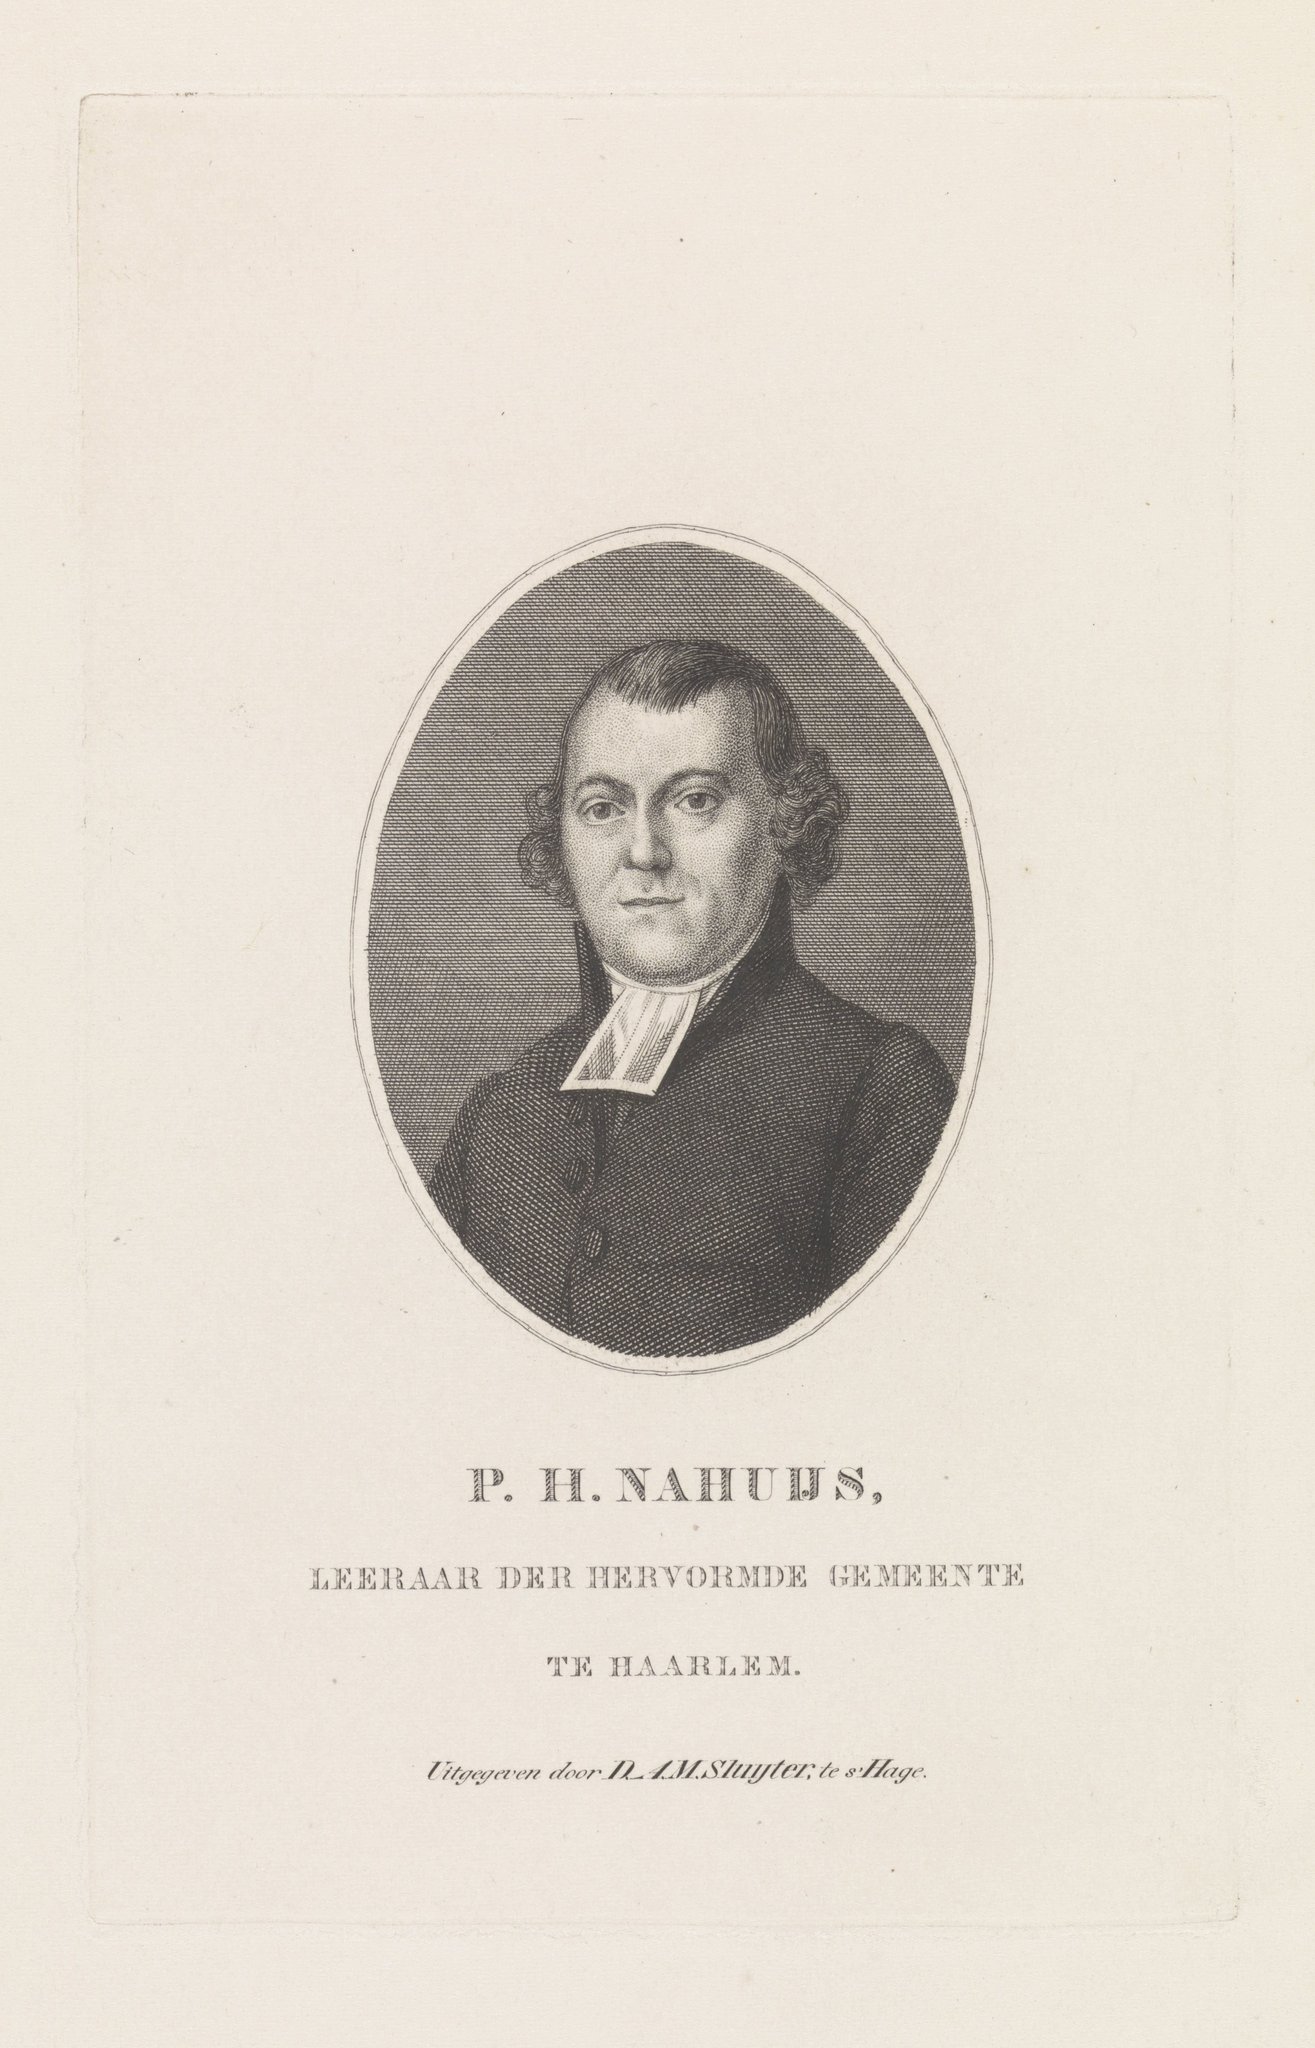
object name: print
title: Portret van Pieter Huibert Nahuys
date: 1810-1837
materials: paper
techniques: engraving, etching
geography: the hague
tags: predikant, pieter huibert nahuys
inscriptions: collector's mark: Lugt 2228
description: Portret van Pieter Huibert Nahuys, Hervormd predikant te Haarlem, gekleed in zwarte jas met een witte bef. Buste naar links in ovaal. Onderaan in de marge een tweeregelige tekst in het Nederlands.